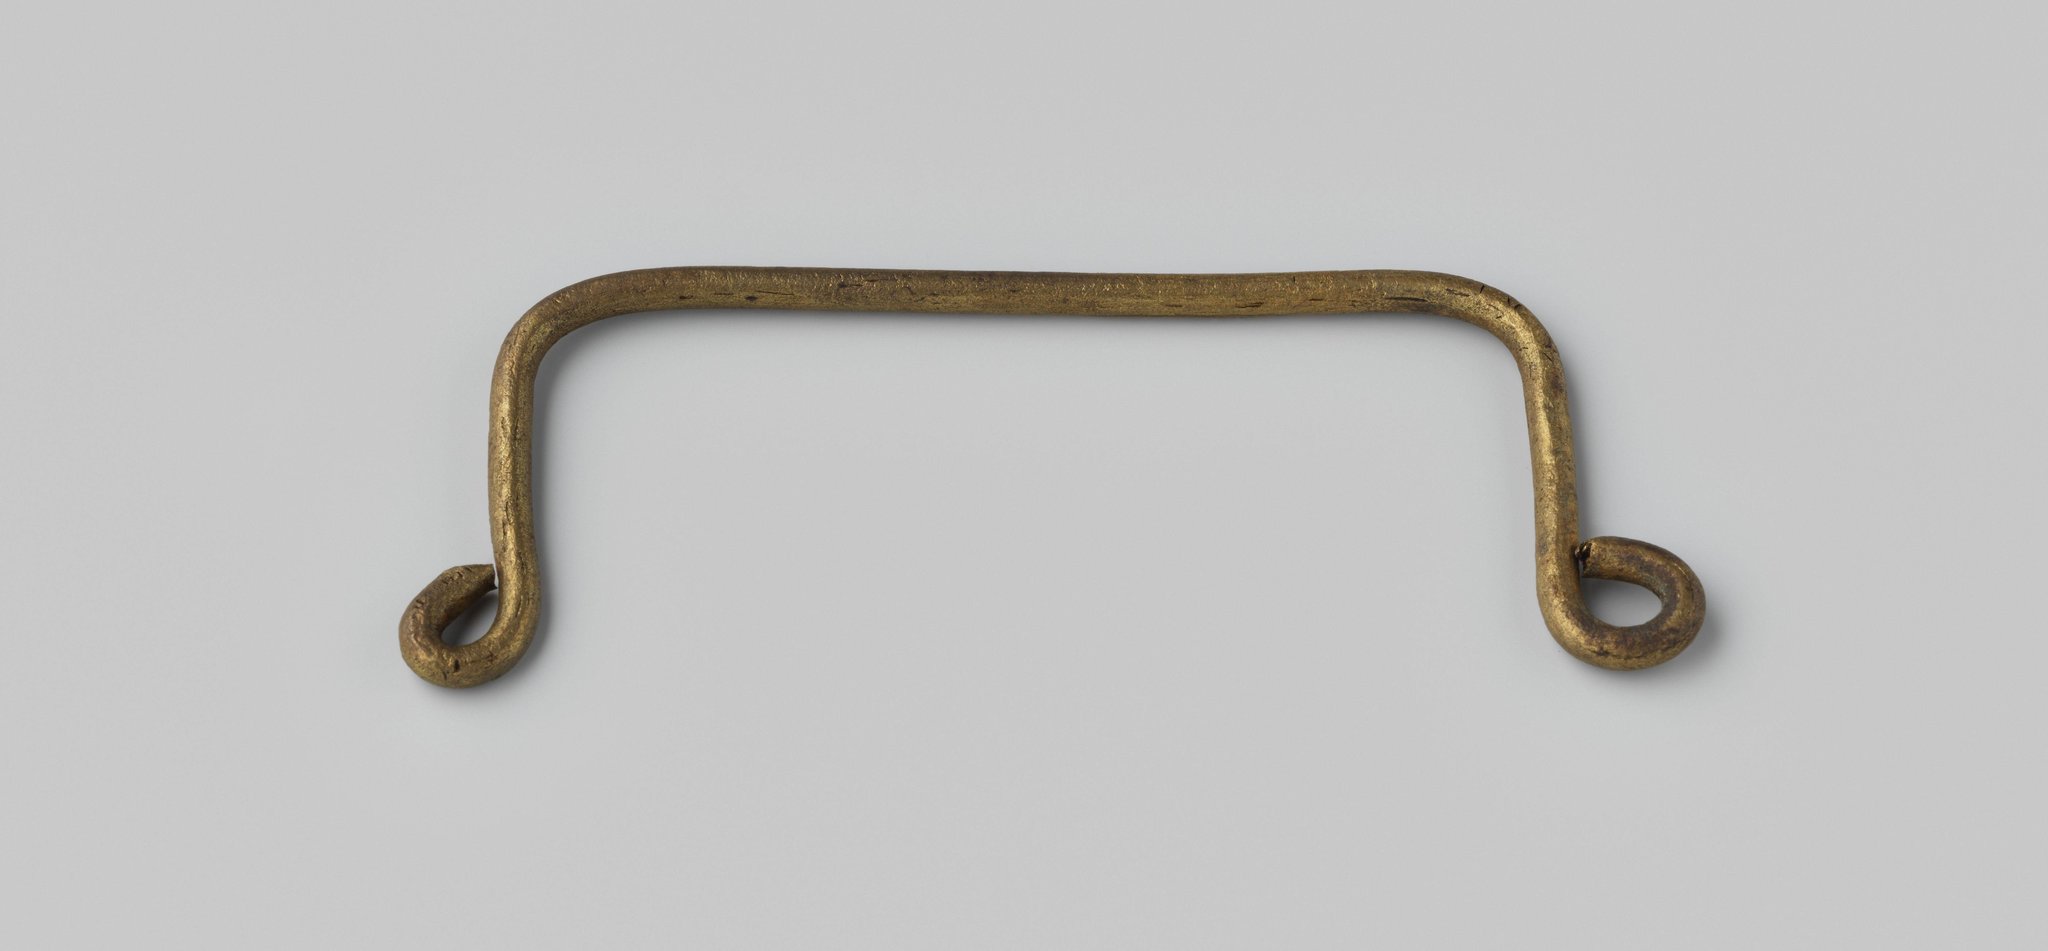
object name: bail handle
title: Beugelhandvat uit het wrak van de Oost-Indiëvaarder Hollandia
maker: Anonymous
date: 1700-1743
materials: copper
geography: netherlands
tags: verenigde oostindische compagnie, hollandia (schip), annet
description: Fittings, handles, bail handle; wire, rectangular, rounded corners, everted ends forming oval eyes.